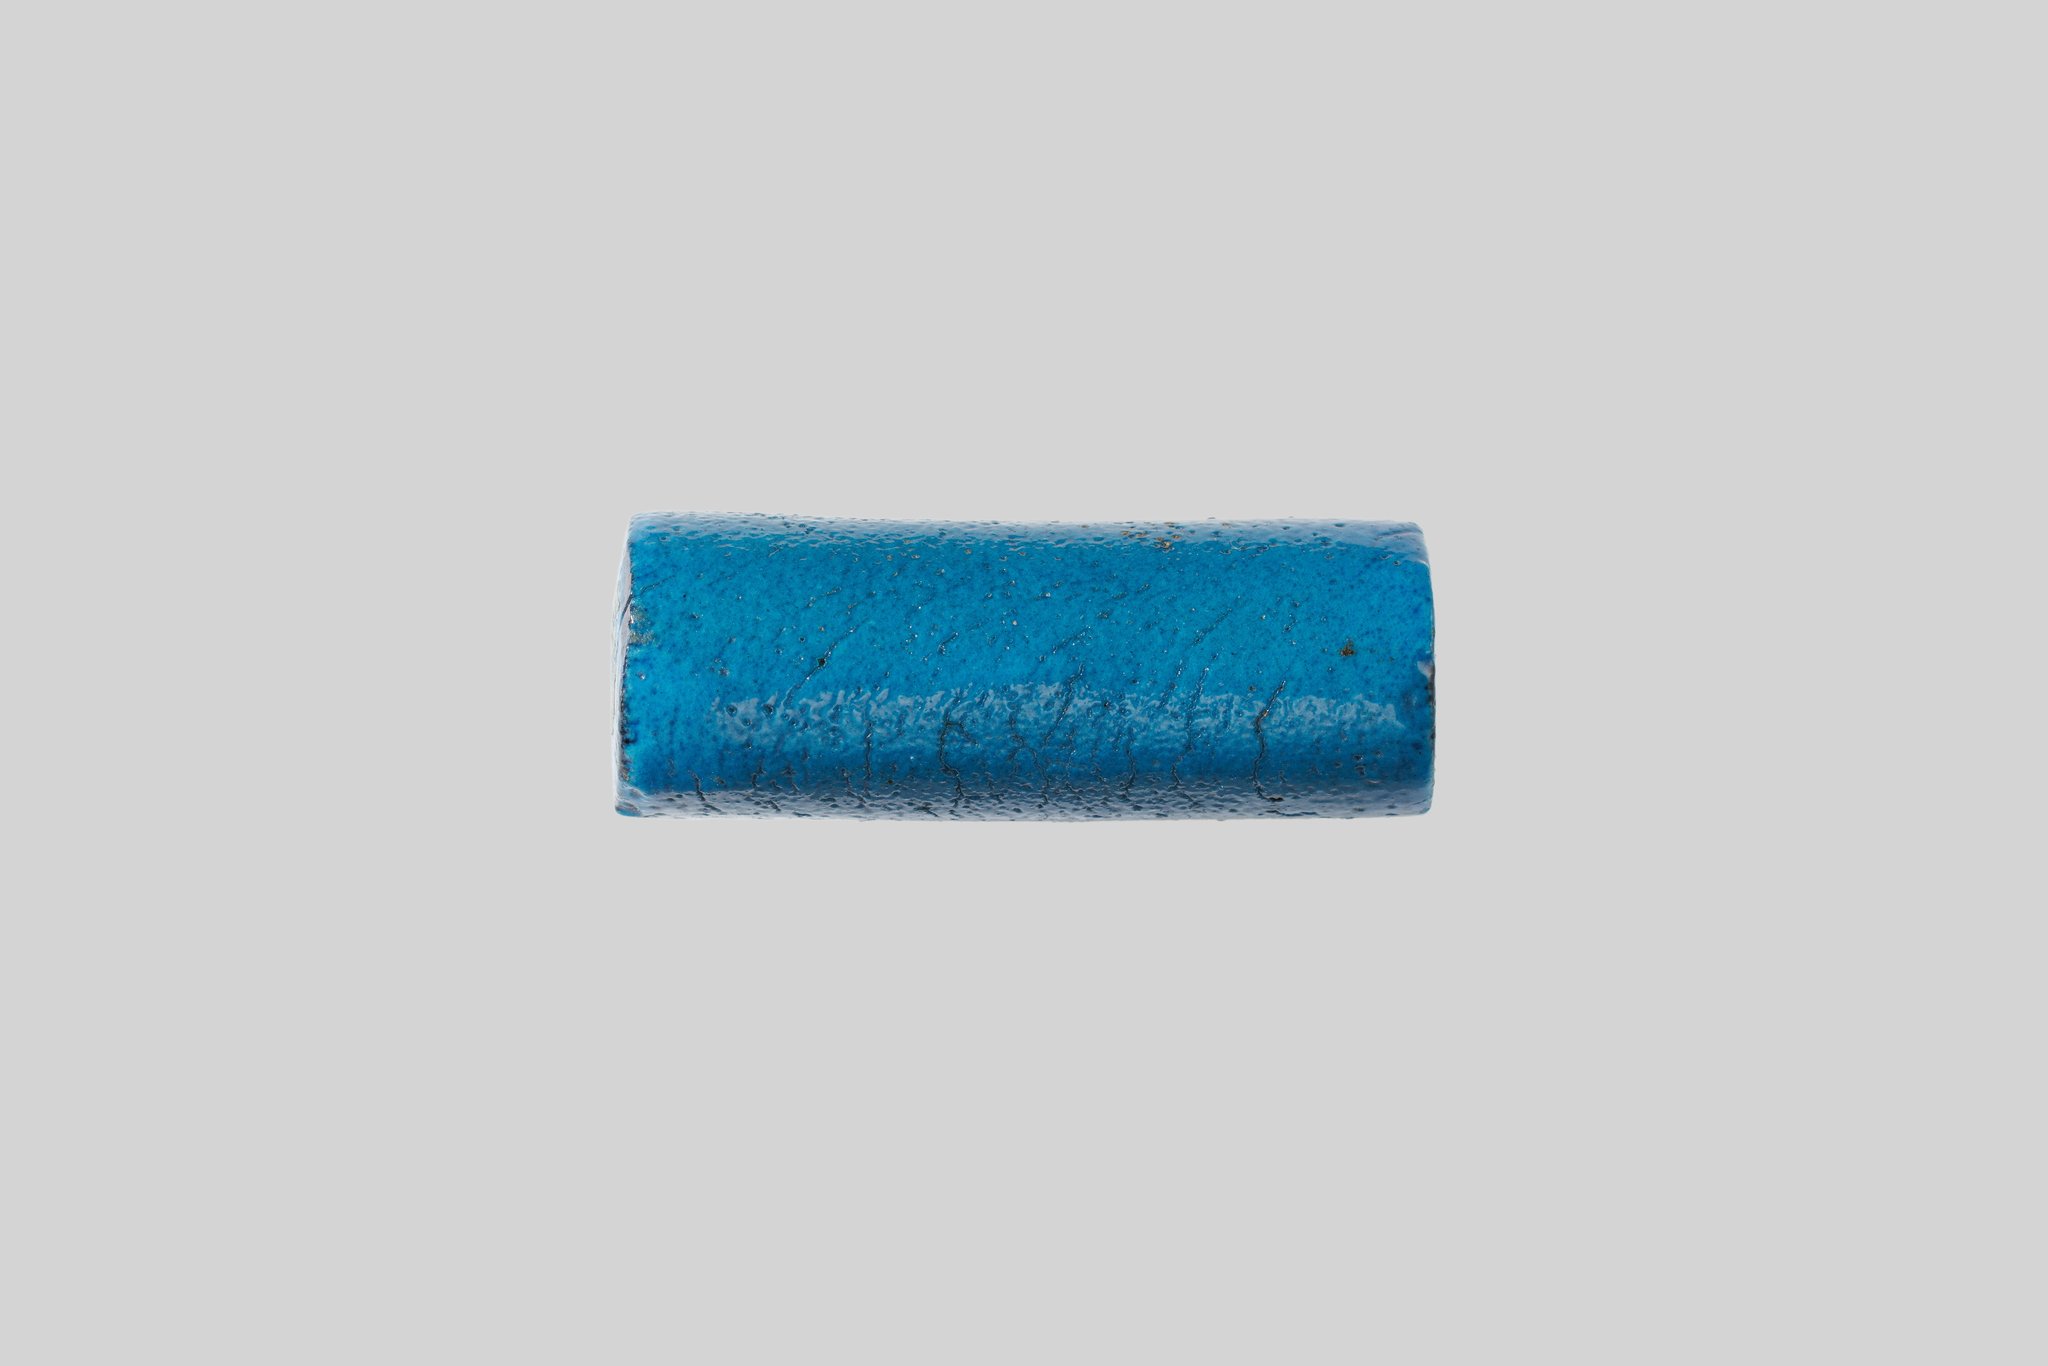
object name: model papyrus roll, thutmose iv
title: Model of Papyrus Roll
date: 1400-1390 BCE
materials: faience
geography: egypt